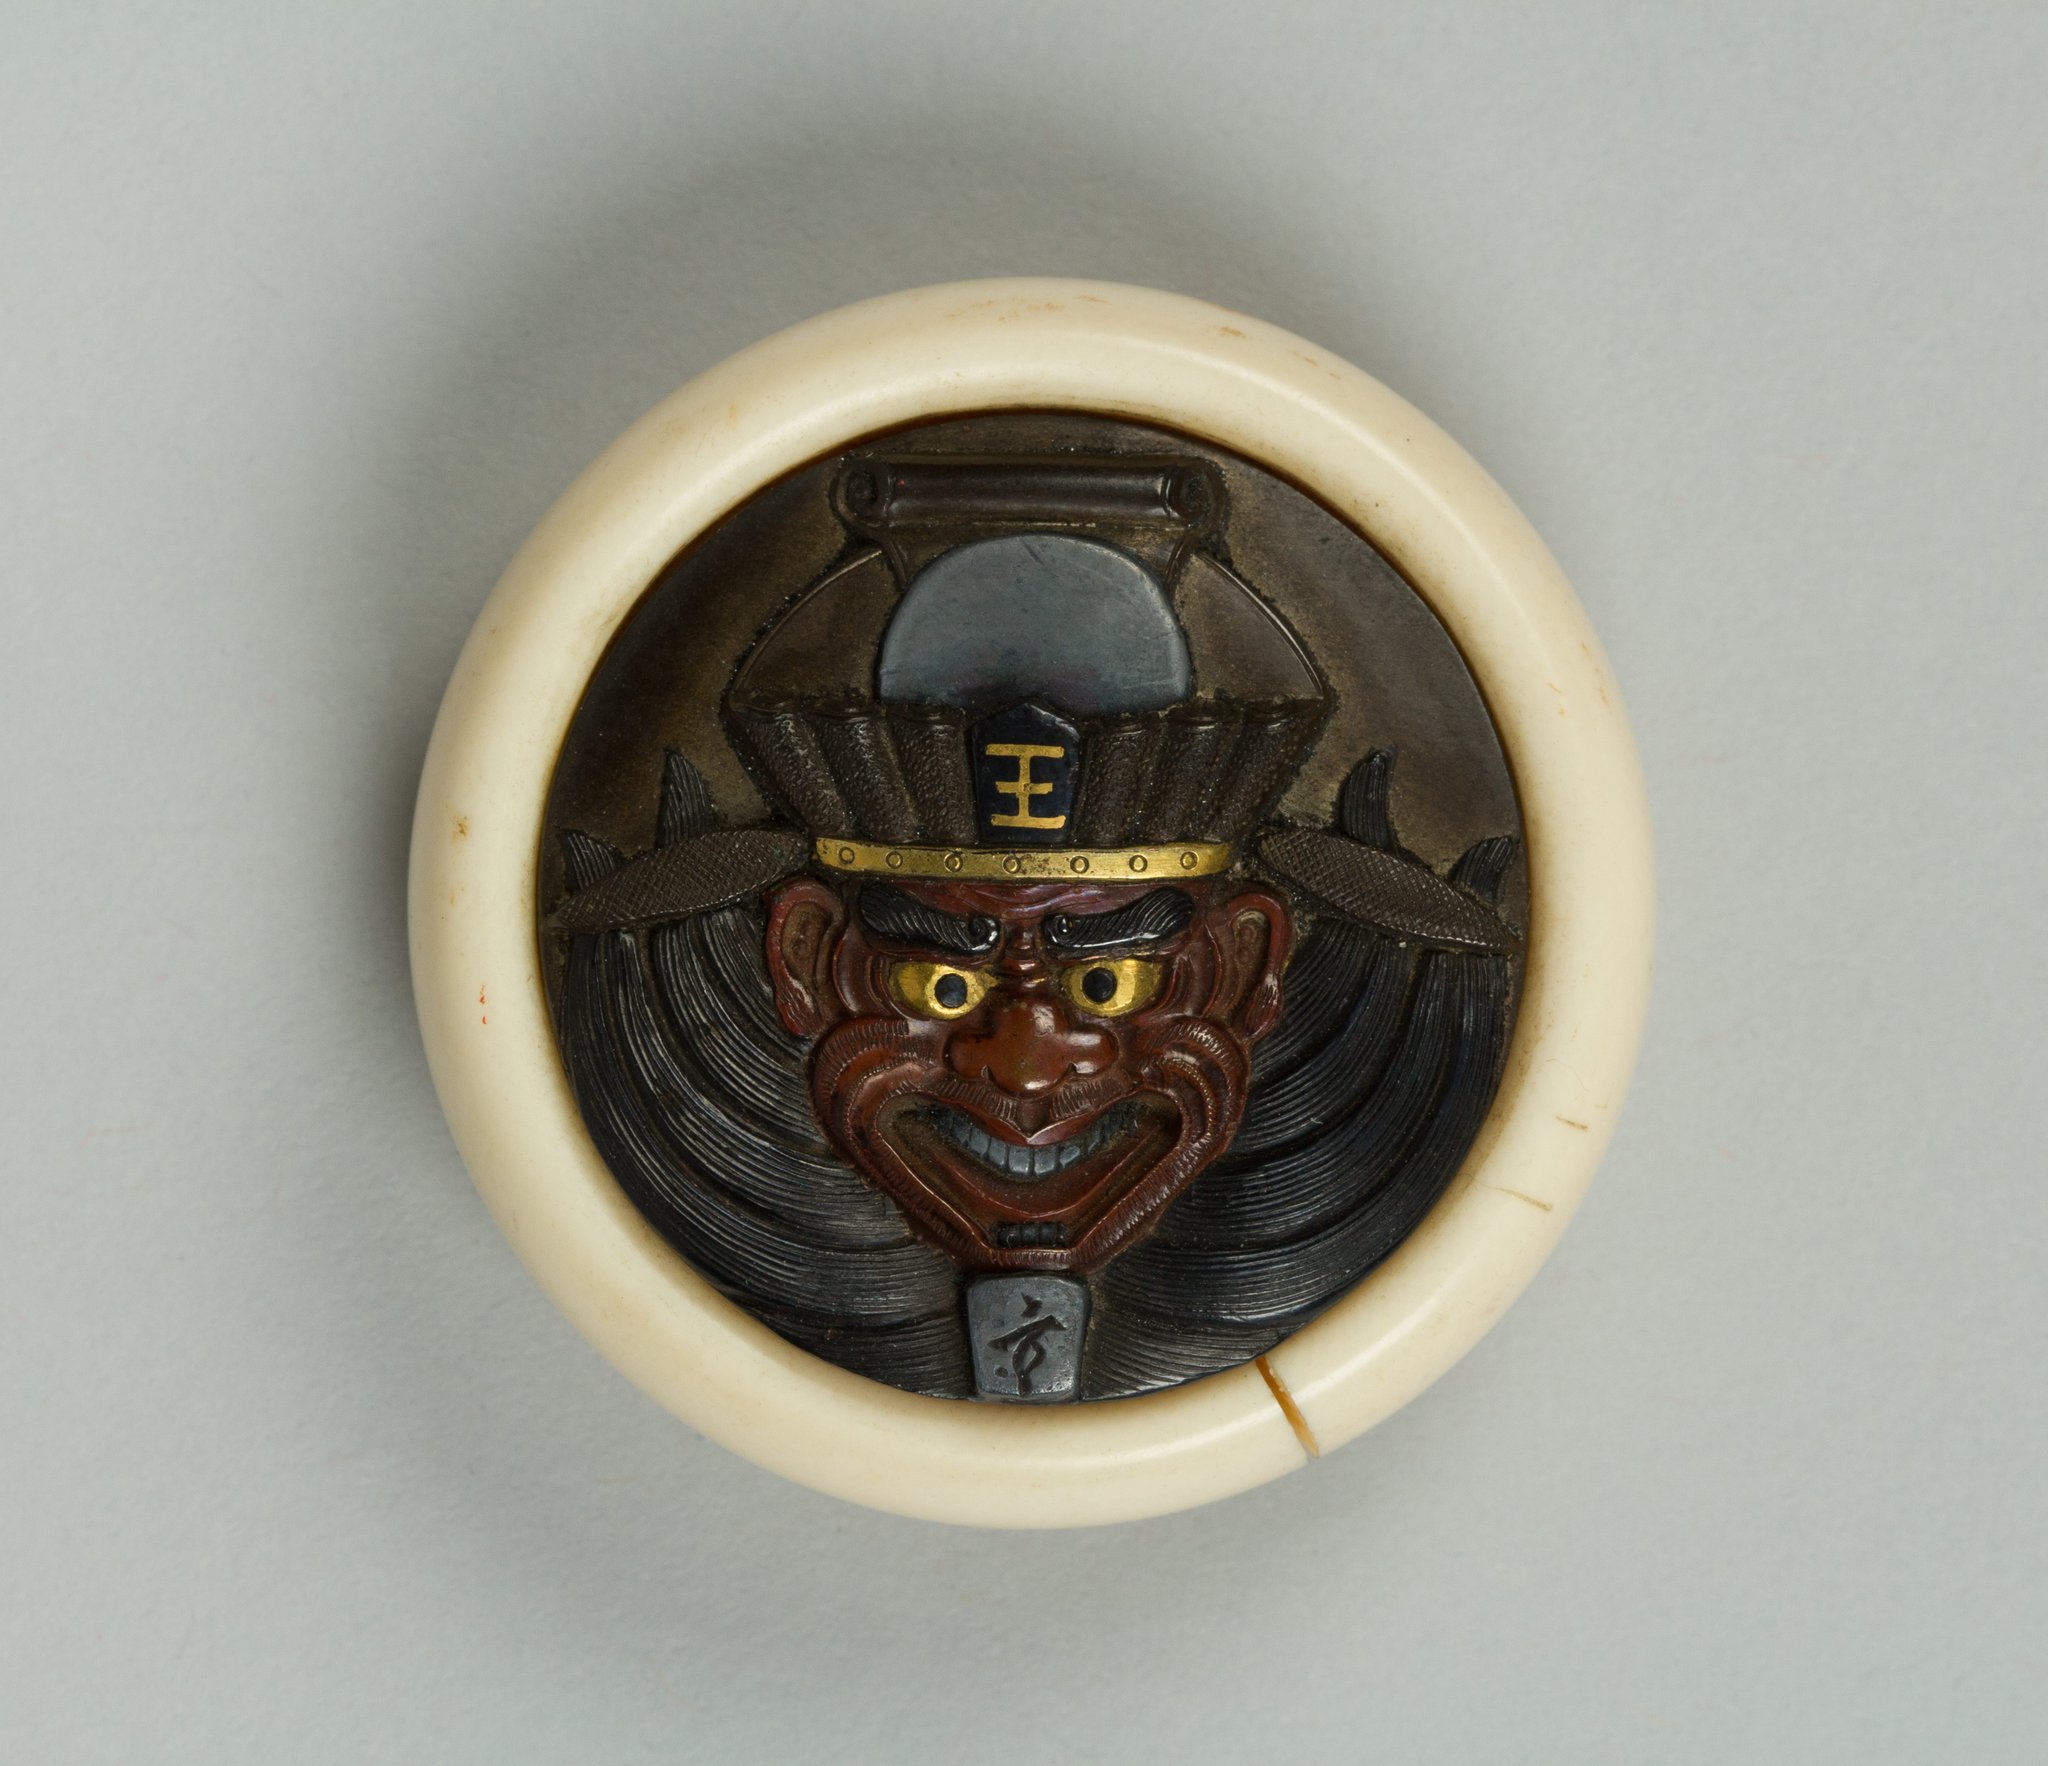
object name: netsuke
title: Netsuke with Head of a Chinese Sage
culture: japanese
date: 1801-1900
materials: ivory, metal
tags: heads